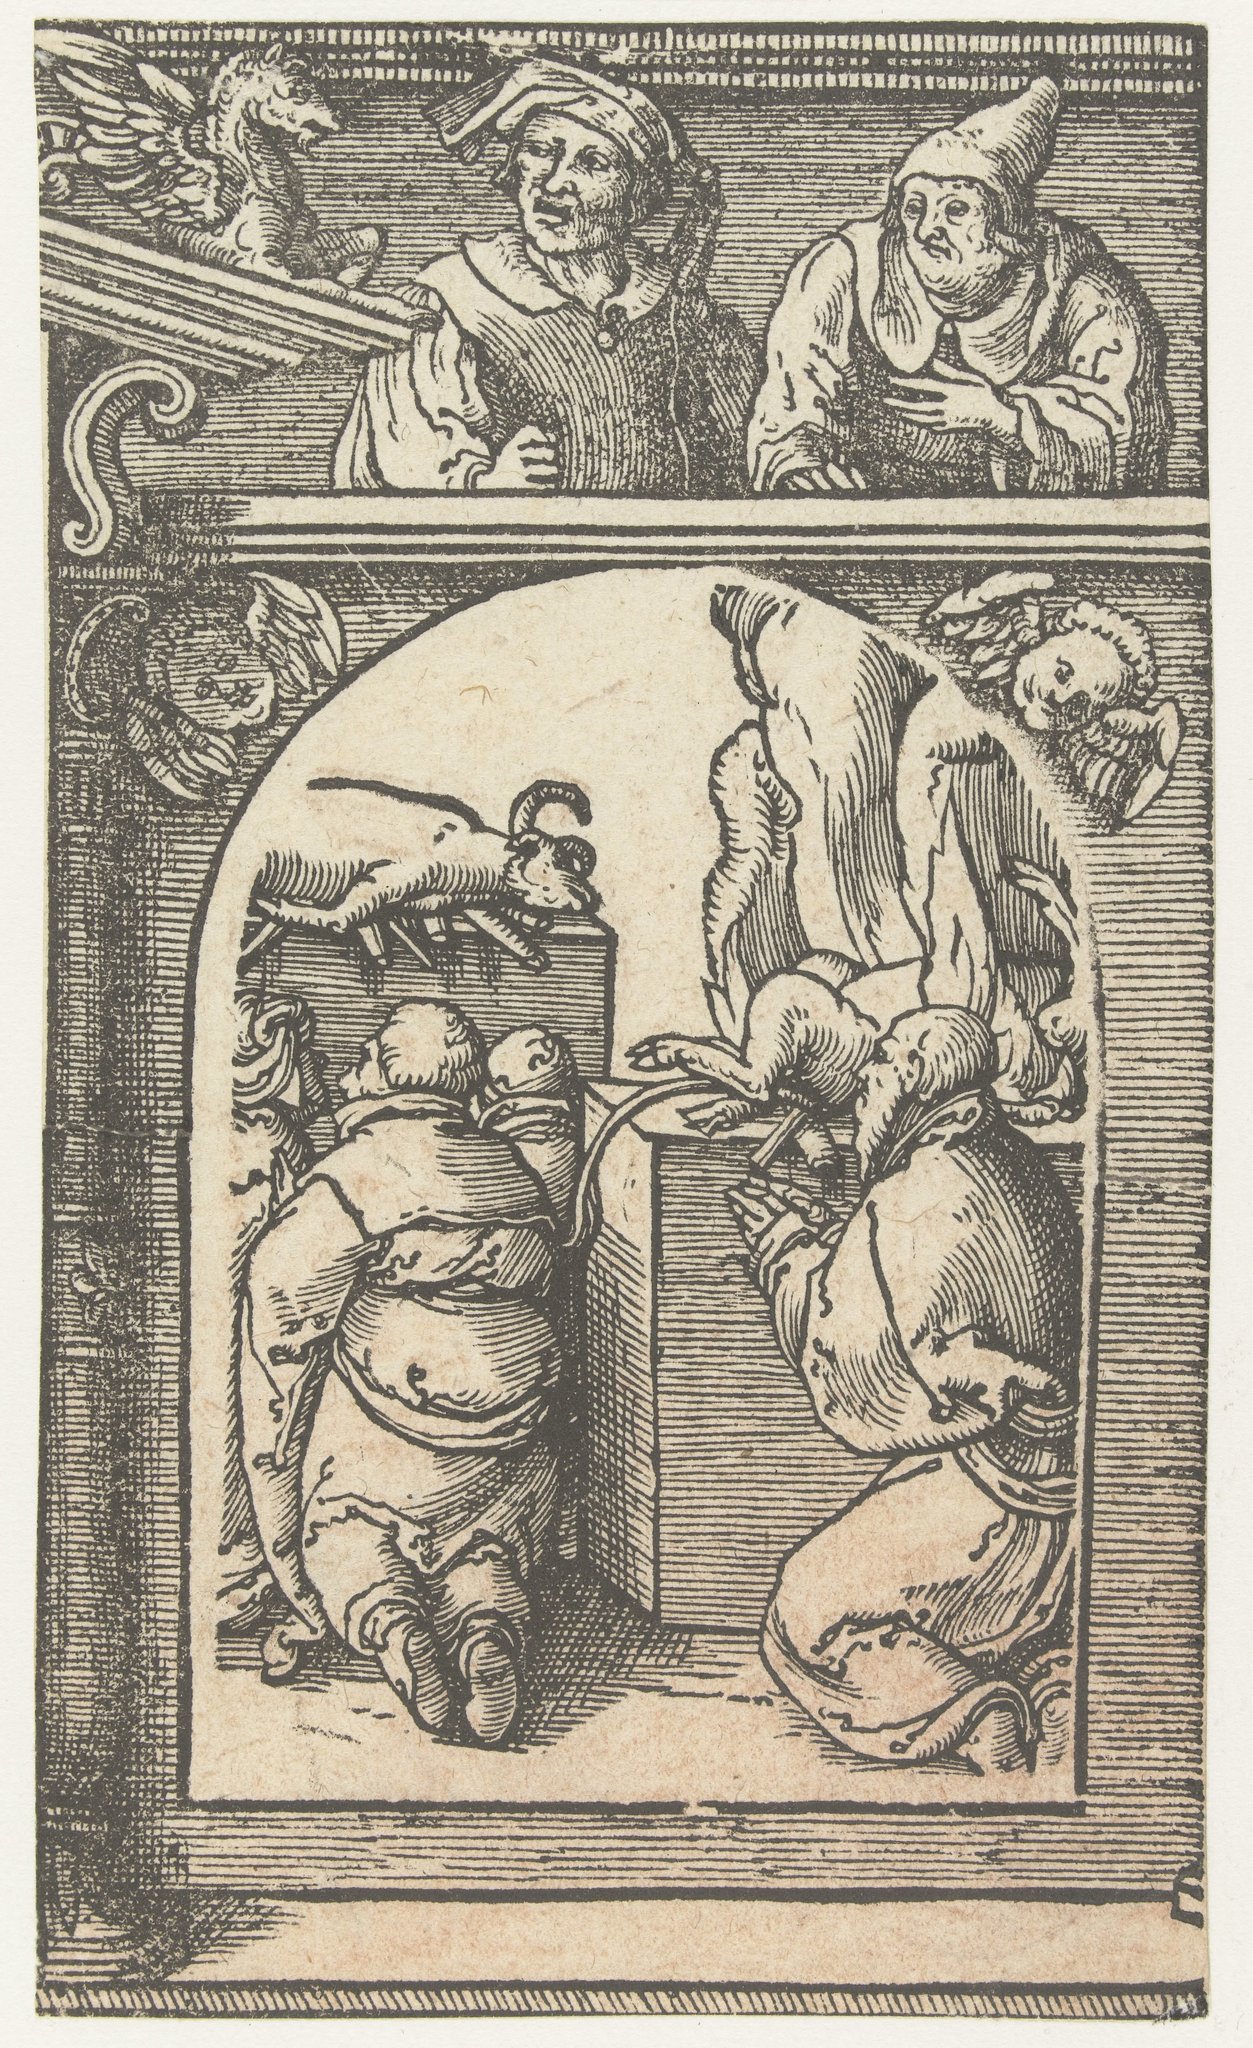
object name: book illustration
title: Elia en de priesters van Baal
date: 1525-1530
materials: paper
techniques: woodcut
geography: low countries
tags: other groups of prophets, two sacrificial altars are set up ~ story of elijah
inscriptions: collector's mark: Lugt 240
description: Fragment van een blad uit een Biblia Pauperum. Elia geknield voor altaar met brandend offerdier, links van hem priesters van Baal knielend voor altaar met offerdier. Omlijsting met twee profeten.